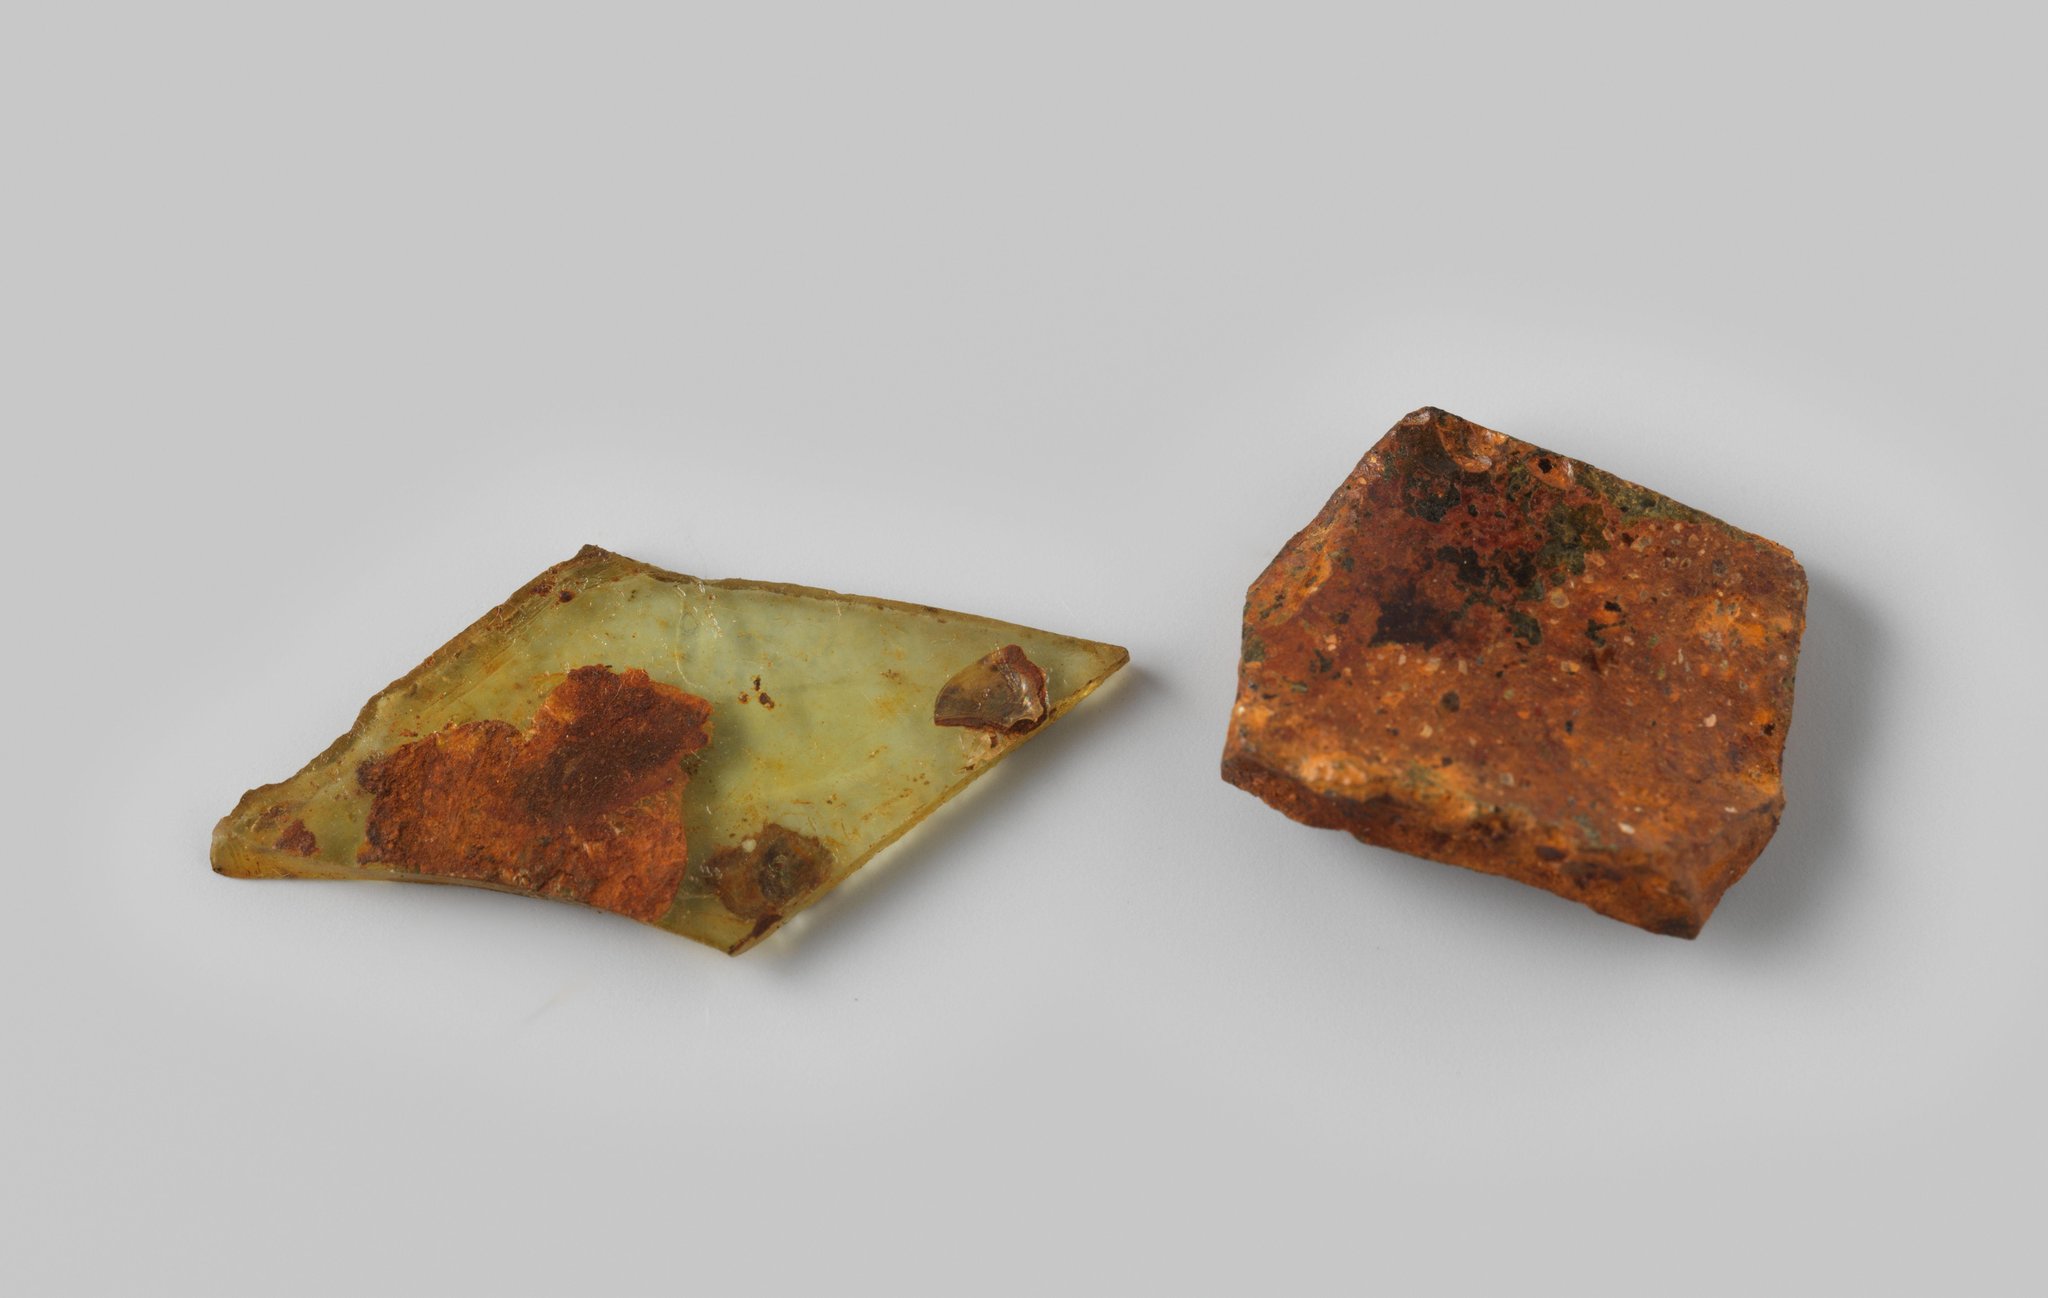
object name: wine bottle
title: Scherven van wijnflessen uit het wrak van de Oost-Indiëvaarder Hollandia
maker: Anonymous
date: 1700-1743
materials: glass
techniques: green glass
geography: netherlands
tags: verenigde oostindische compagnie, hollandia (schip), annet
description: Typologically not identifiable, belly, fragment.